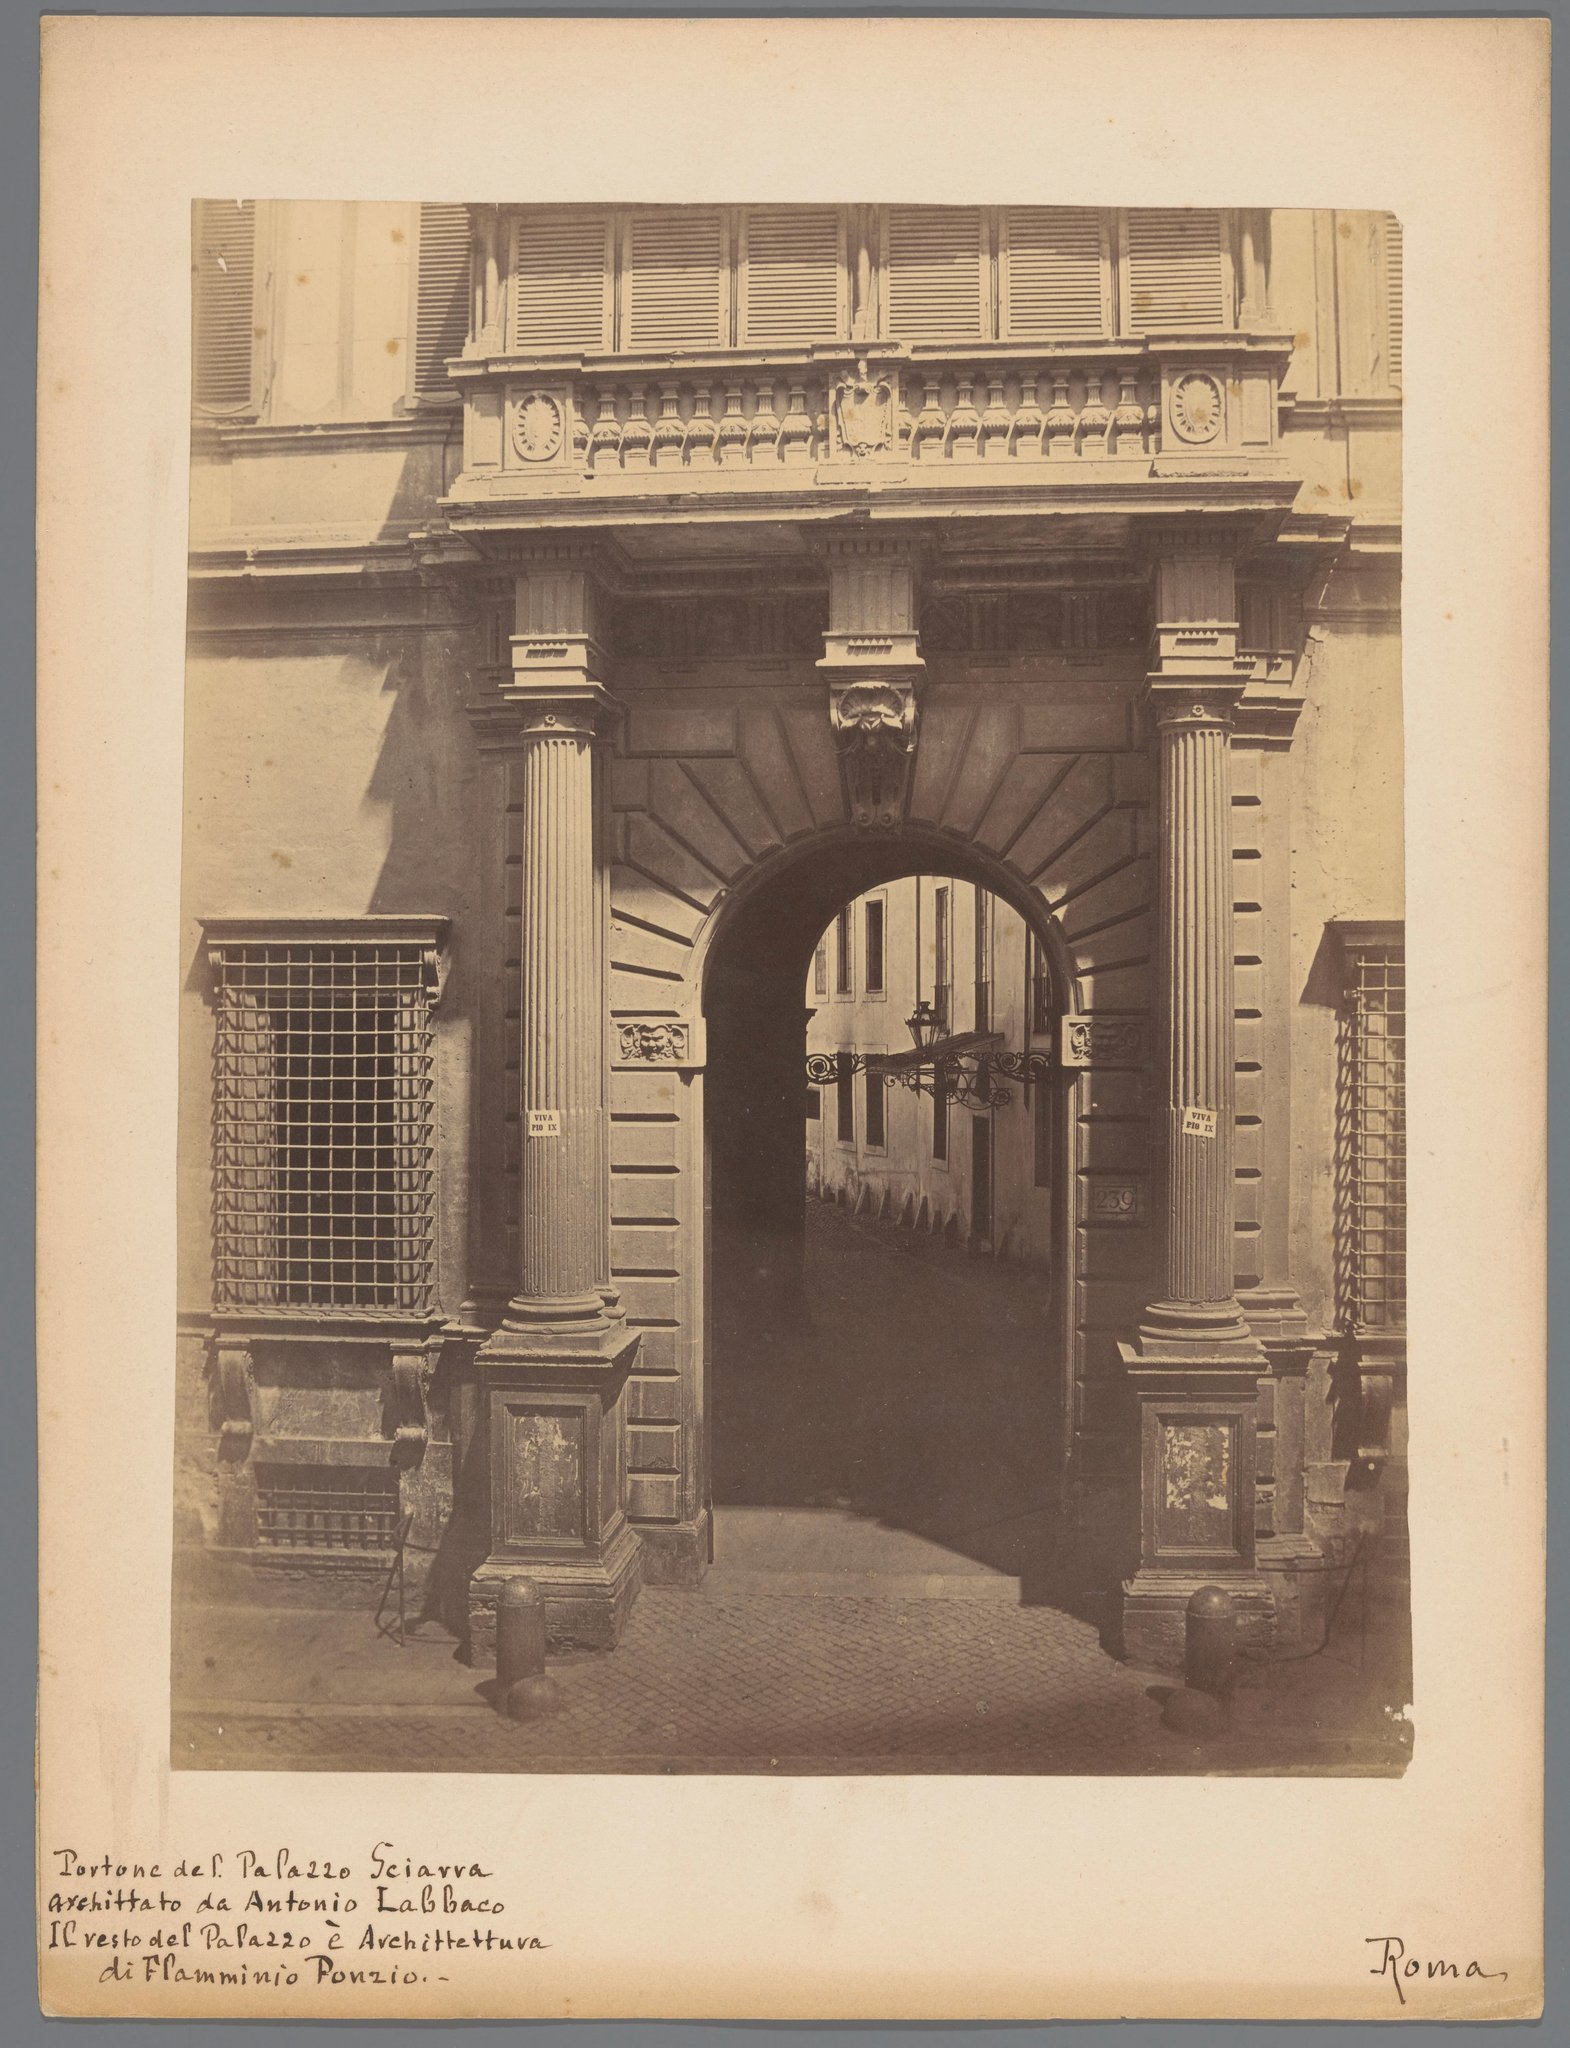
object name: photograph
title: Portone del. Palazzo Sciarra archittato da Antonio Labbaco Il resto del Palazzo è Archittettura di Flamminio Ponzio.- Roma.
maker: Anonymous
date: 1875-1900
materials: cardboard, photographic support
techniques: albumen print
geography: rome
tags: palace, gate, entrance, balcony, rome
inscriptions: collector's mark: Lugt 3937